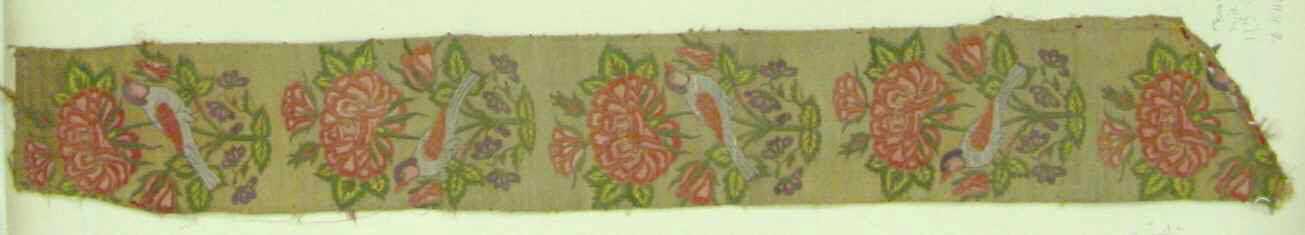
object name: textile fragment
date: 1601-1700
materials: metal thread, silk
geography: iran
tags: flowers